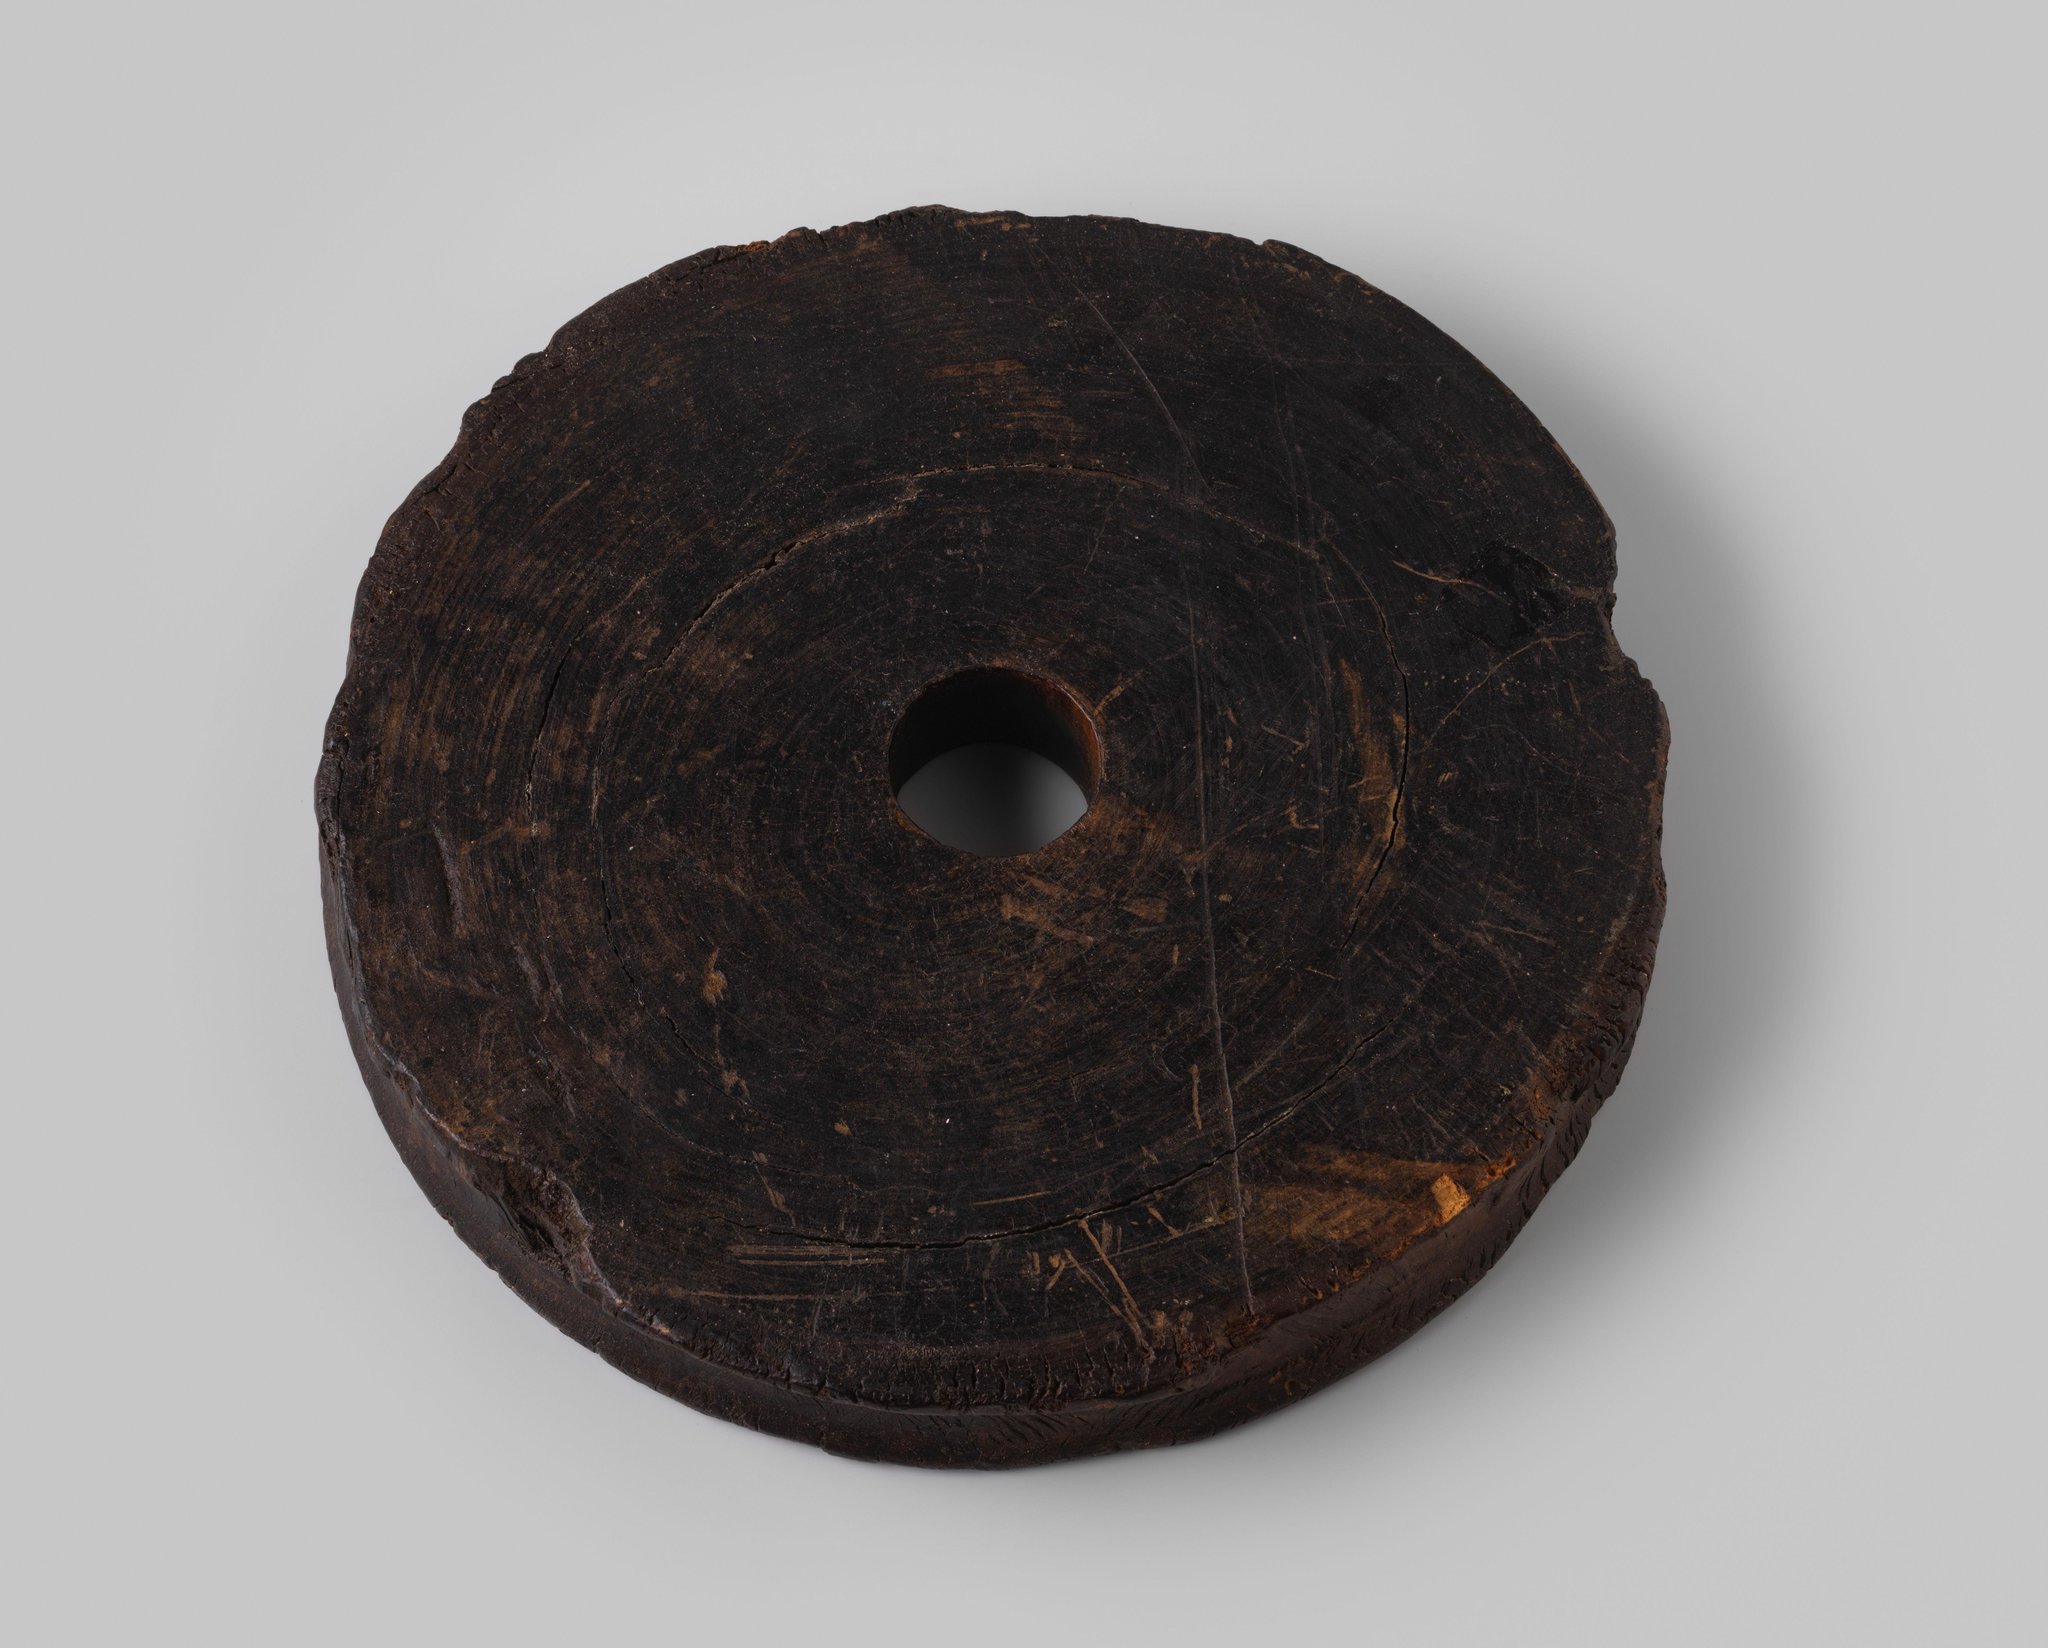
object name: disk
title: Wheel of a block from the wreck of the Dutch East Indiaman Hollandia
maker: Anonymous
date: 1700-1743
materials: wood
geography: netherlands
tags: verenigde oostindische compagnie, hollandia (schip), annet